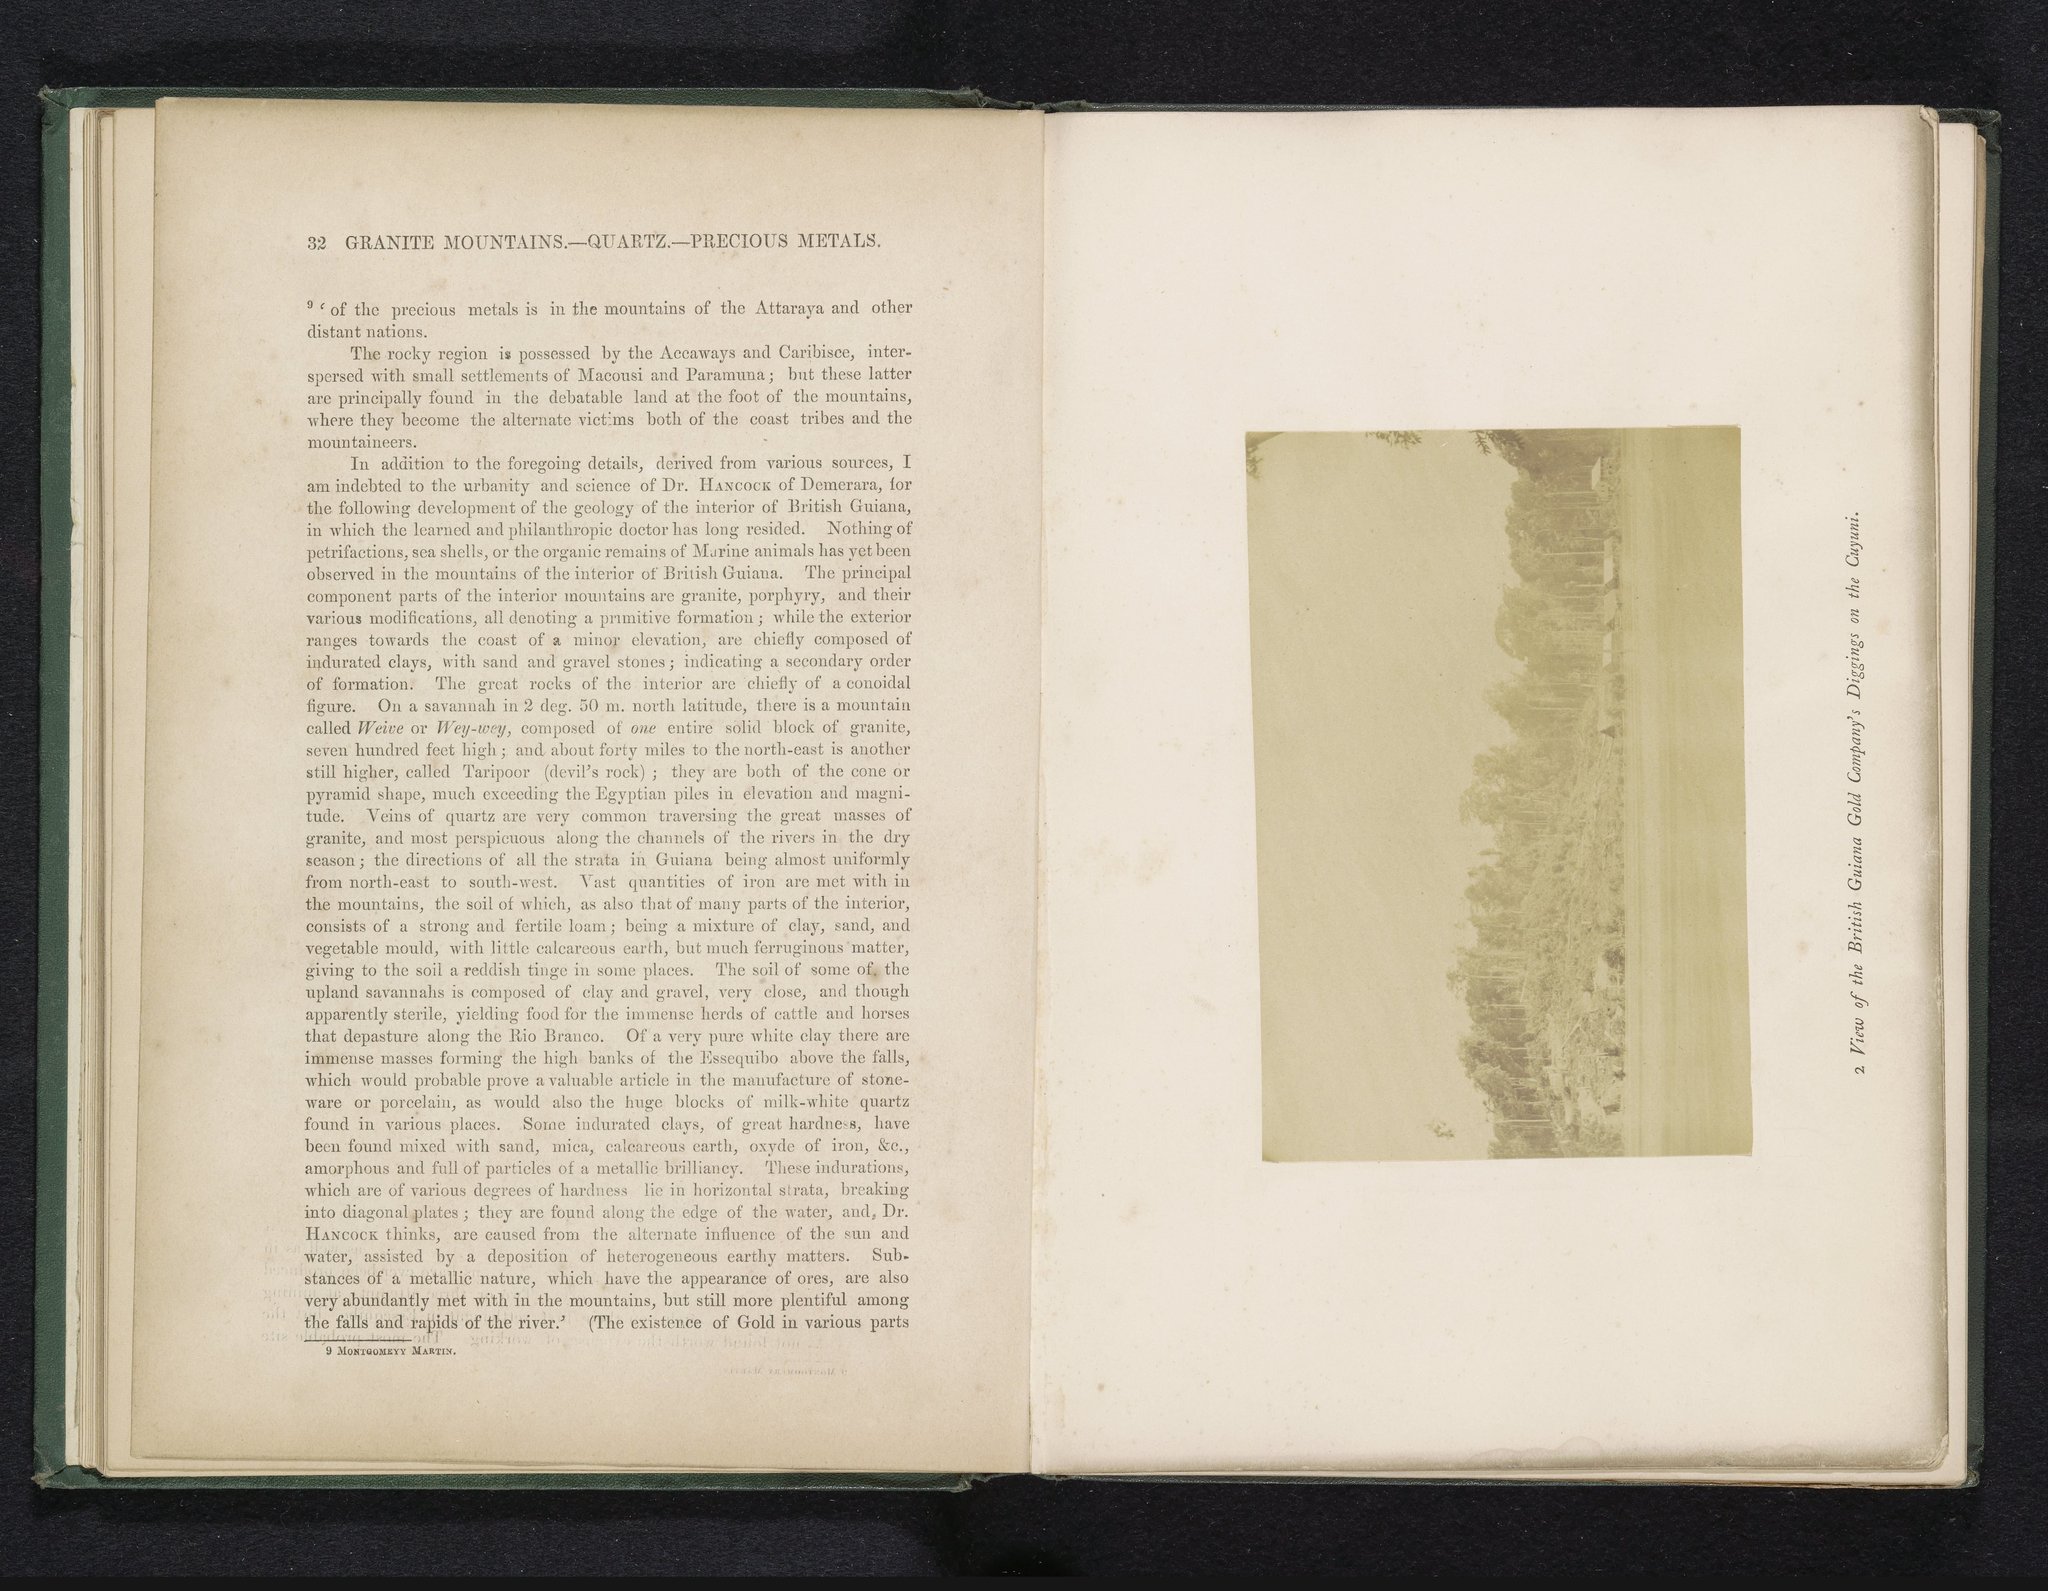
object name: photograph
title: View of the British Guiana Gold Company's Diggings on the Cuyuni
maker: Anonymous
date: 1856-1866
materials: photographic support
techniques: albumen print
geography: guyana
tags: river, minerals and metals: gold, trees: palm-tree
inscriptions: number: ‘2’